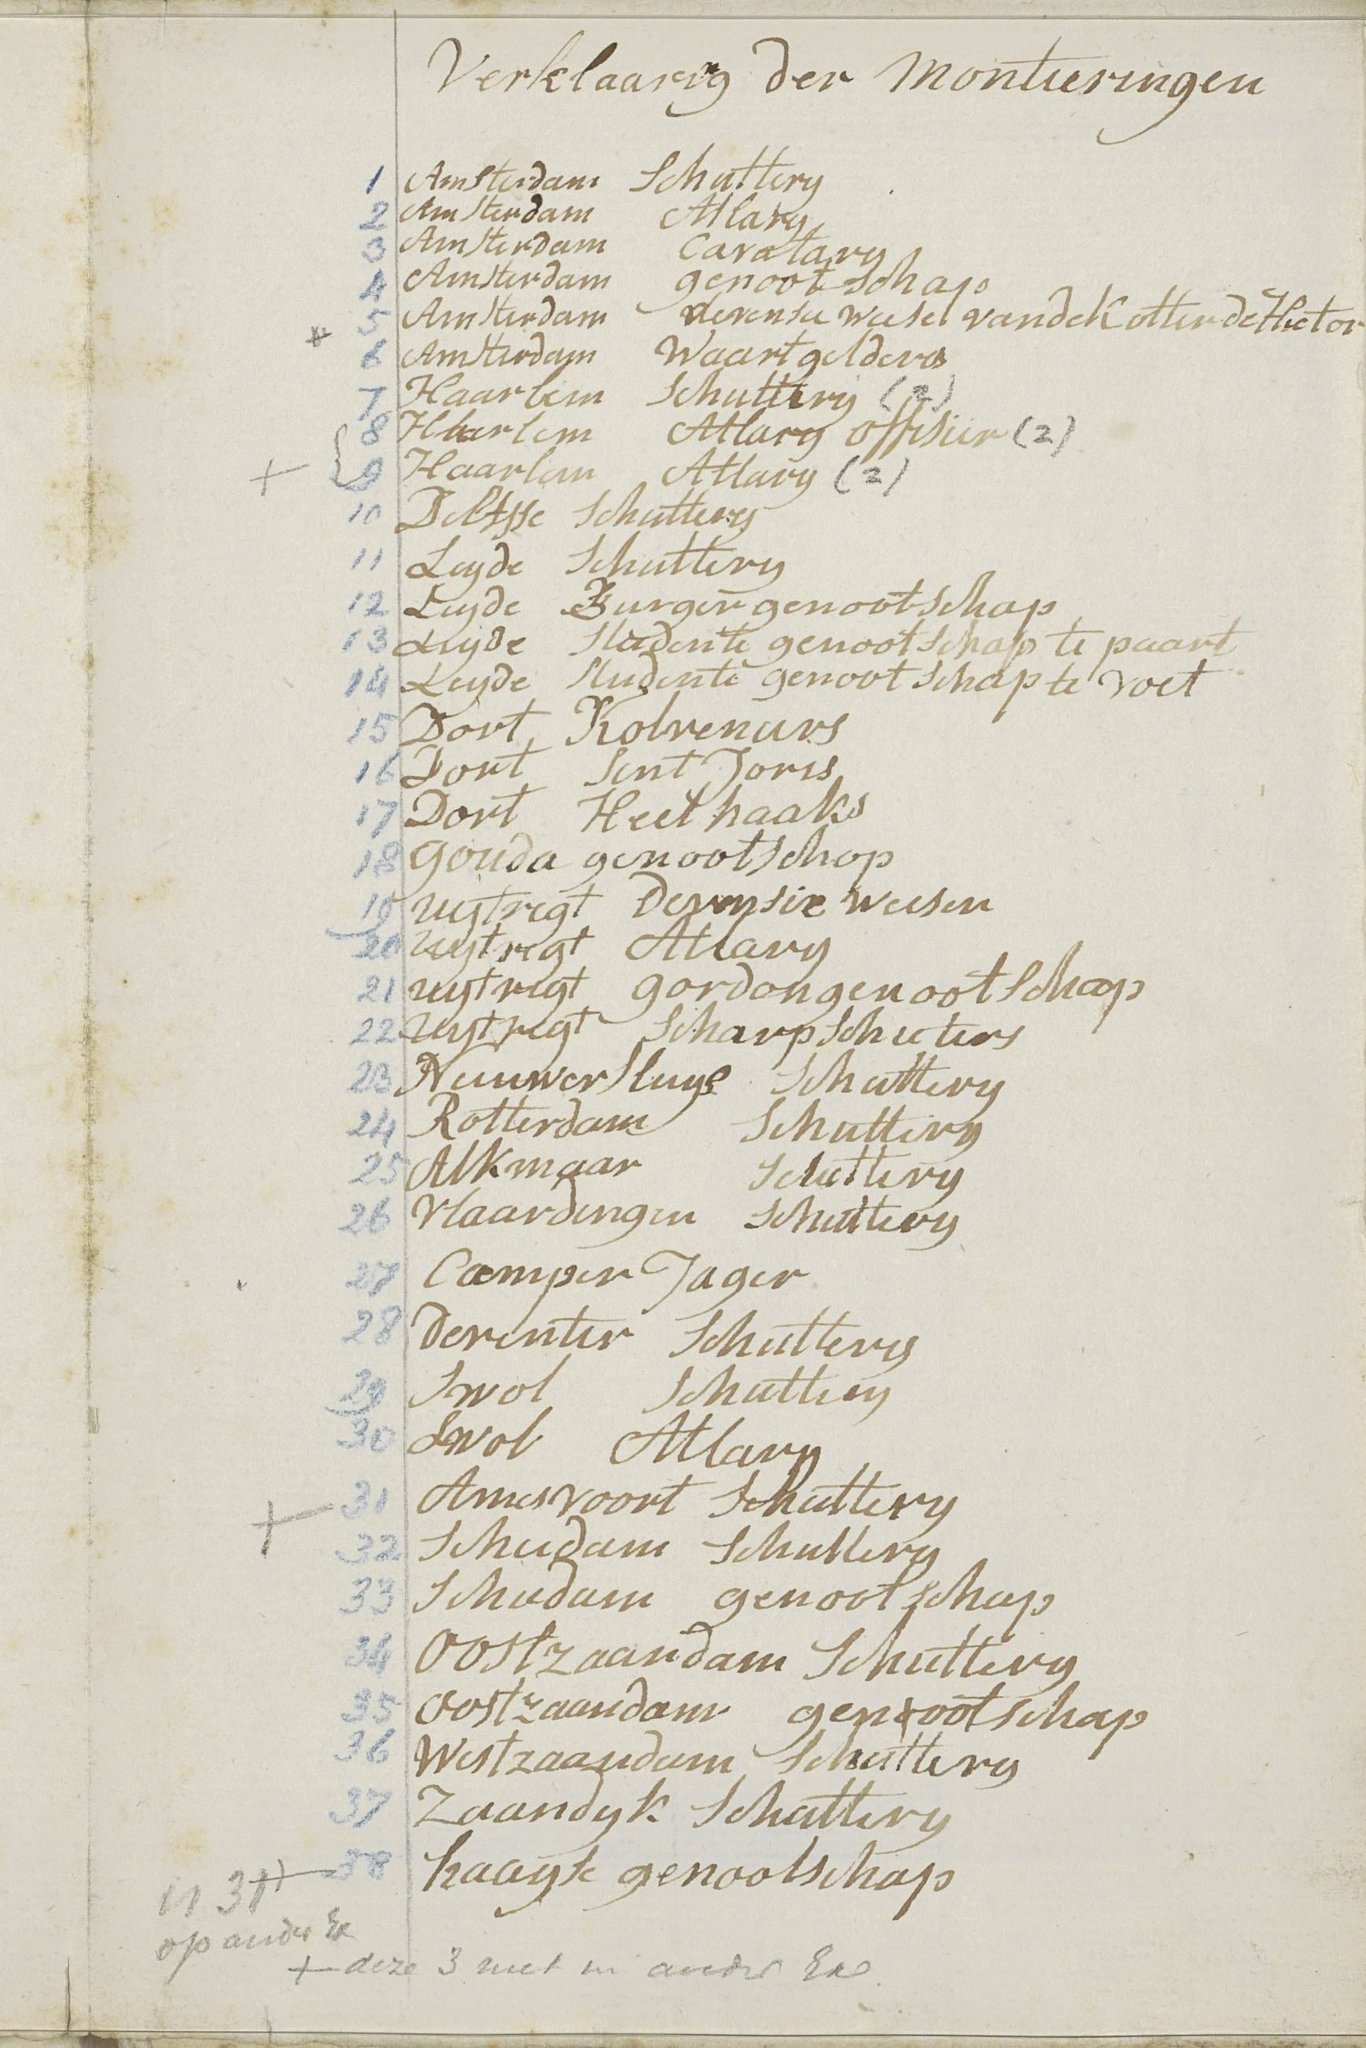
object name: manuscript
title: Verklaaring der Monteeringen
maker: Anonymous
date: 1789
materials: paper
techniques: writing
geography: northern netherlands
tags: (military) uniforms (+ citizen soldiery, civil guard, citizen militia), patriots (1780-1795)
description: Handgeschreven inhoudsopgave met een lijst met de namen van de afgebeelde monteringen, met later bijgeschreven nummers 1-38. Onderdeel van een schetsboek met 41 gekleurde tekeningen van de monteringen van de gewapende schutterijen en burgercorpsen in Nederland, 1789.